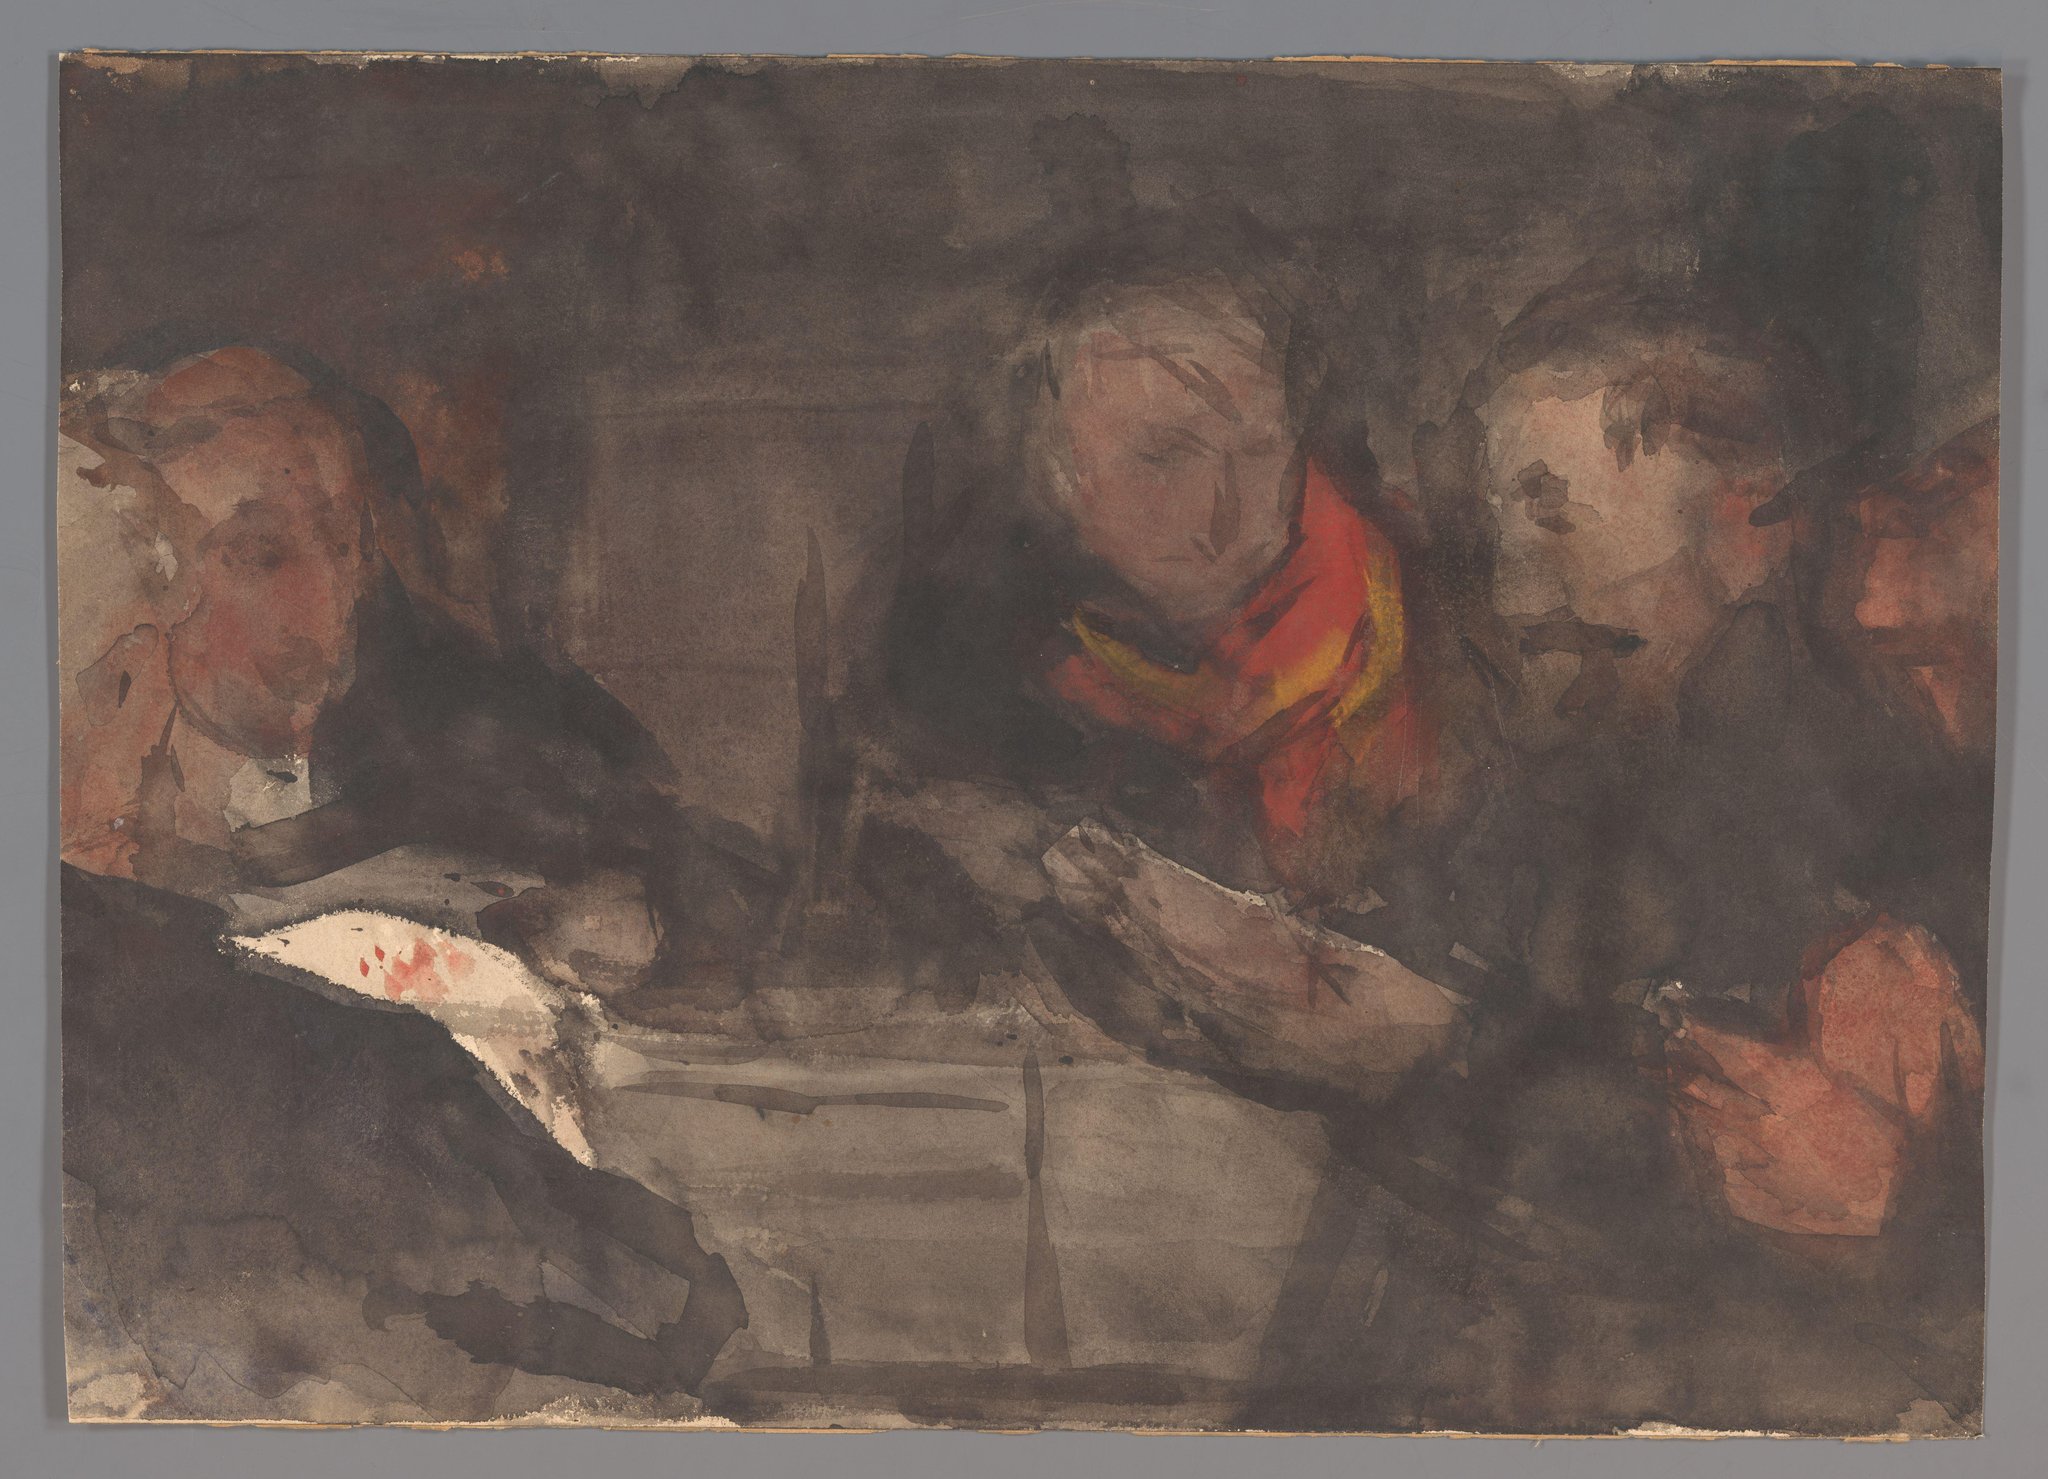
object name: drawing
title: Groep mannen om een tafel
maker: carel adolph lion cachet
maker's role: draughtsman, print maker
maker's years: 1864-1945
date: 1874-1945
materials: paper, watercolor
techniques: brush